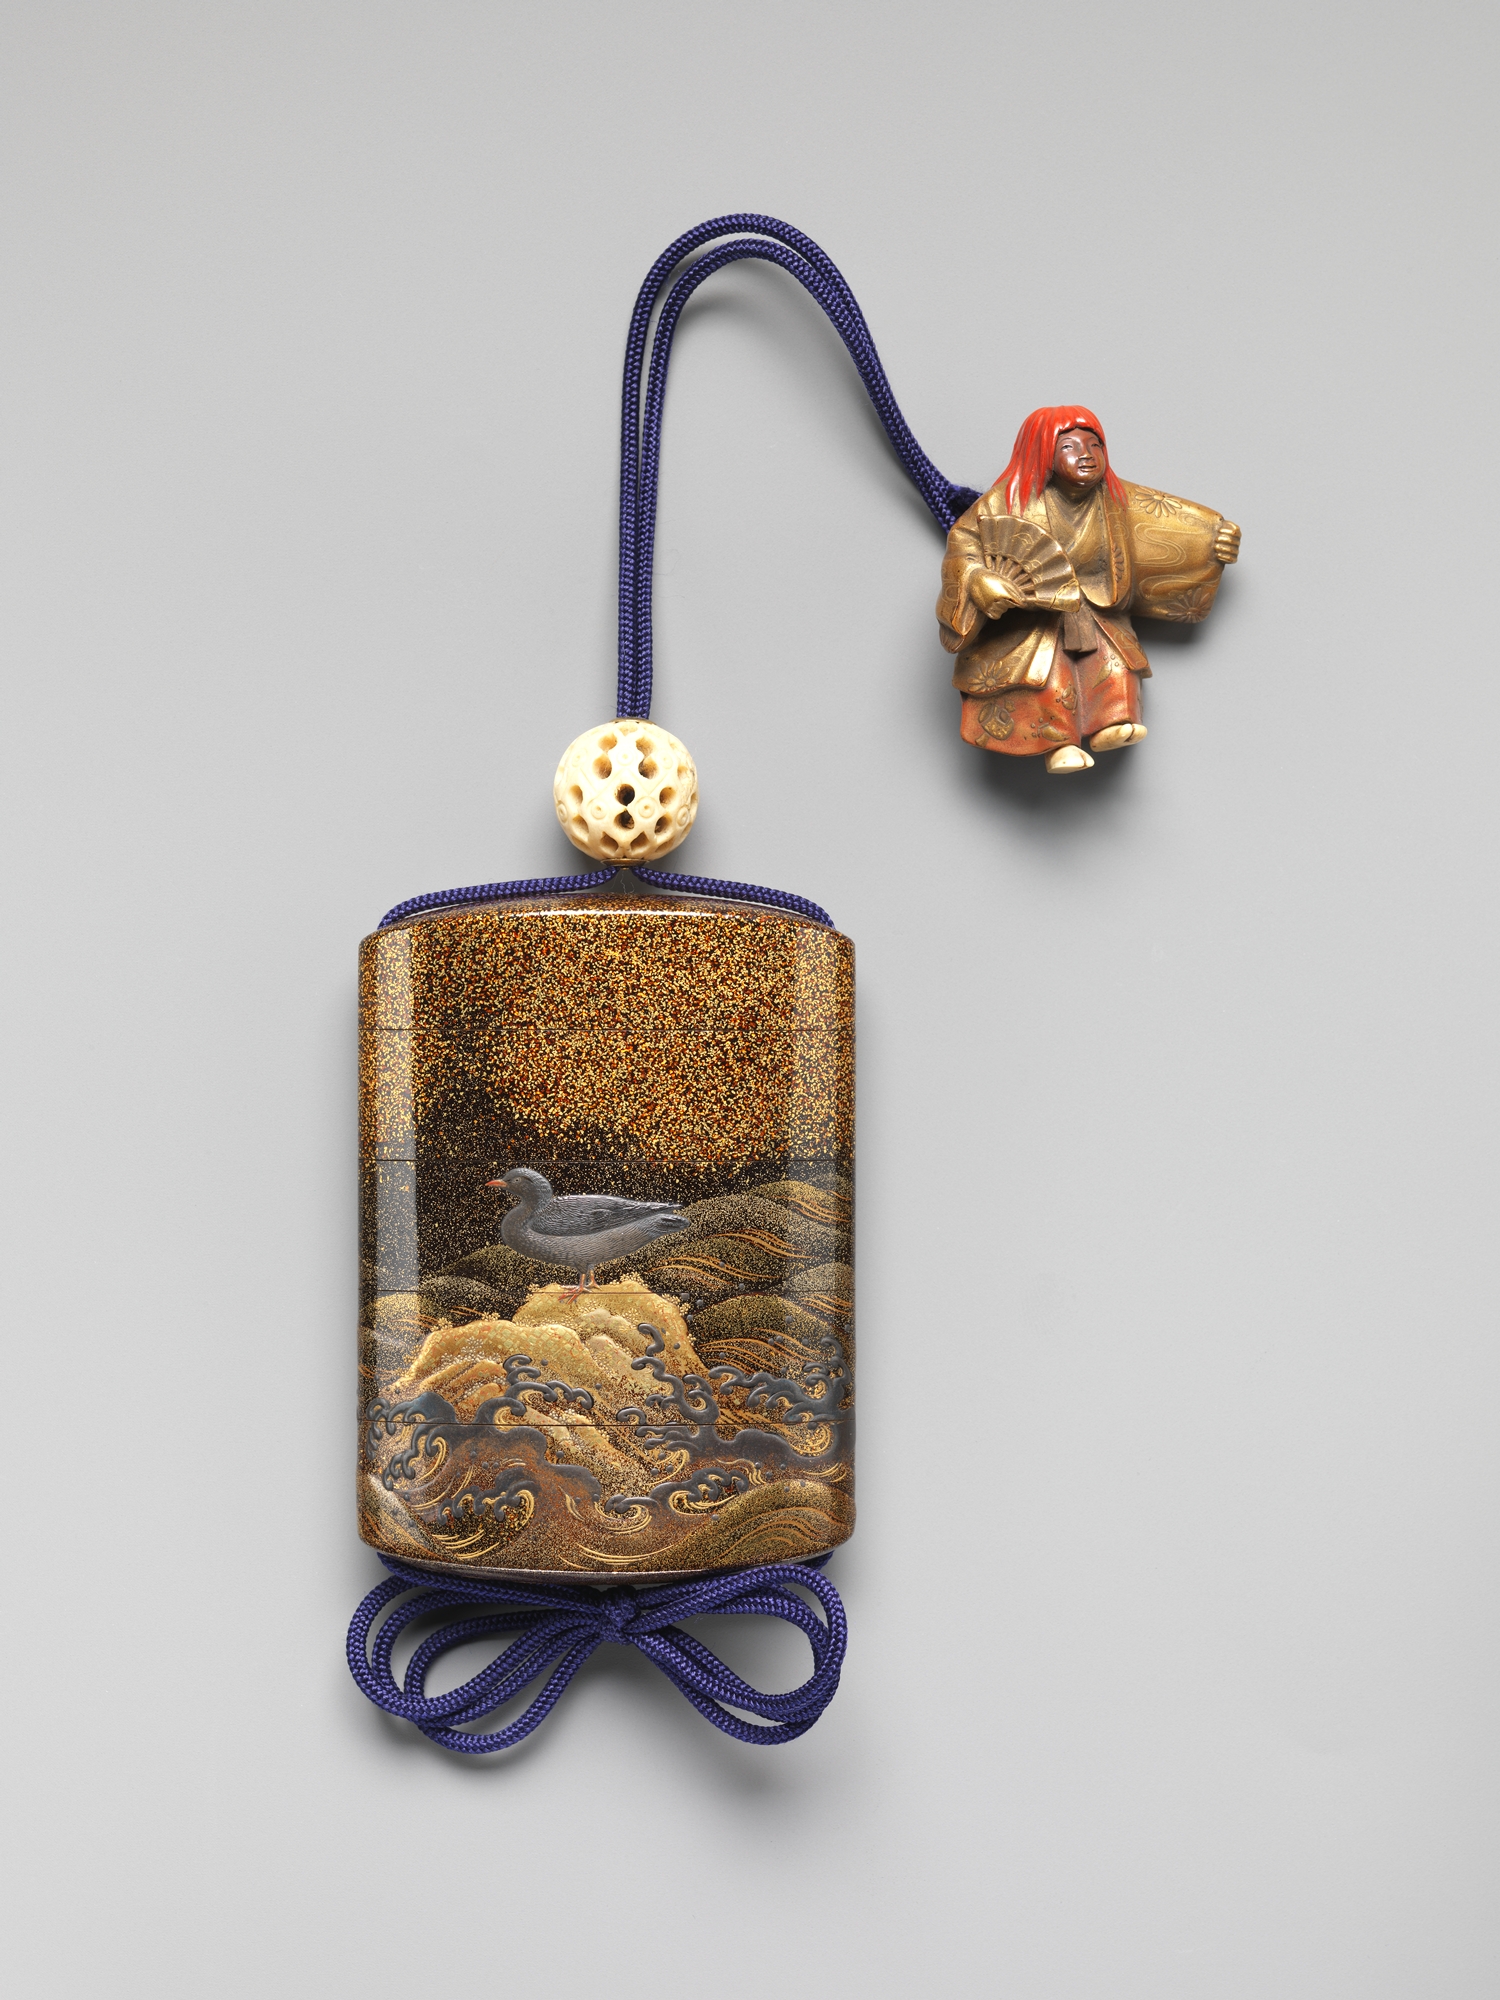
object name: inrō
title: Case (Inrō) with Design of Bird on Standing on Rocks (obverse) Bird Flying above Waves (reverse)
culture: japanese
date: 1801-1900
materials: gold, lacquer, silver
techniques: fundame, hiramakie, roiro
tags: human figures,birds,waves